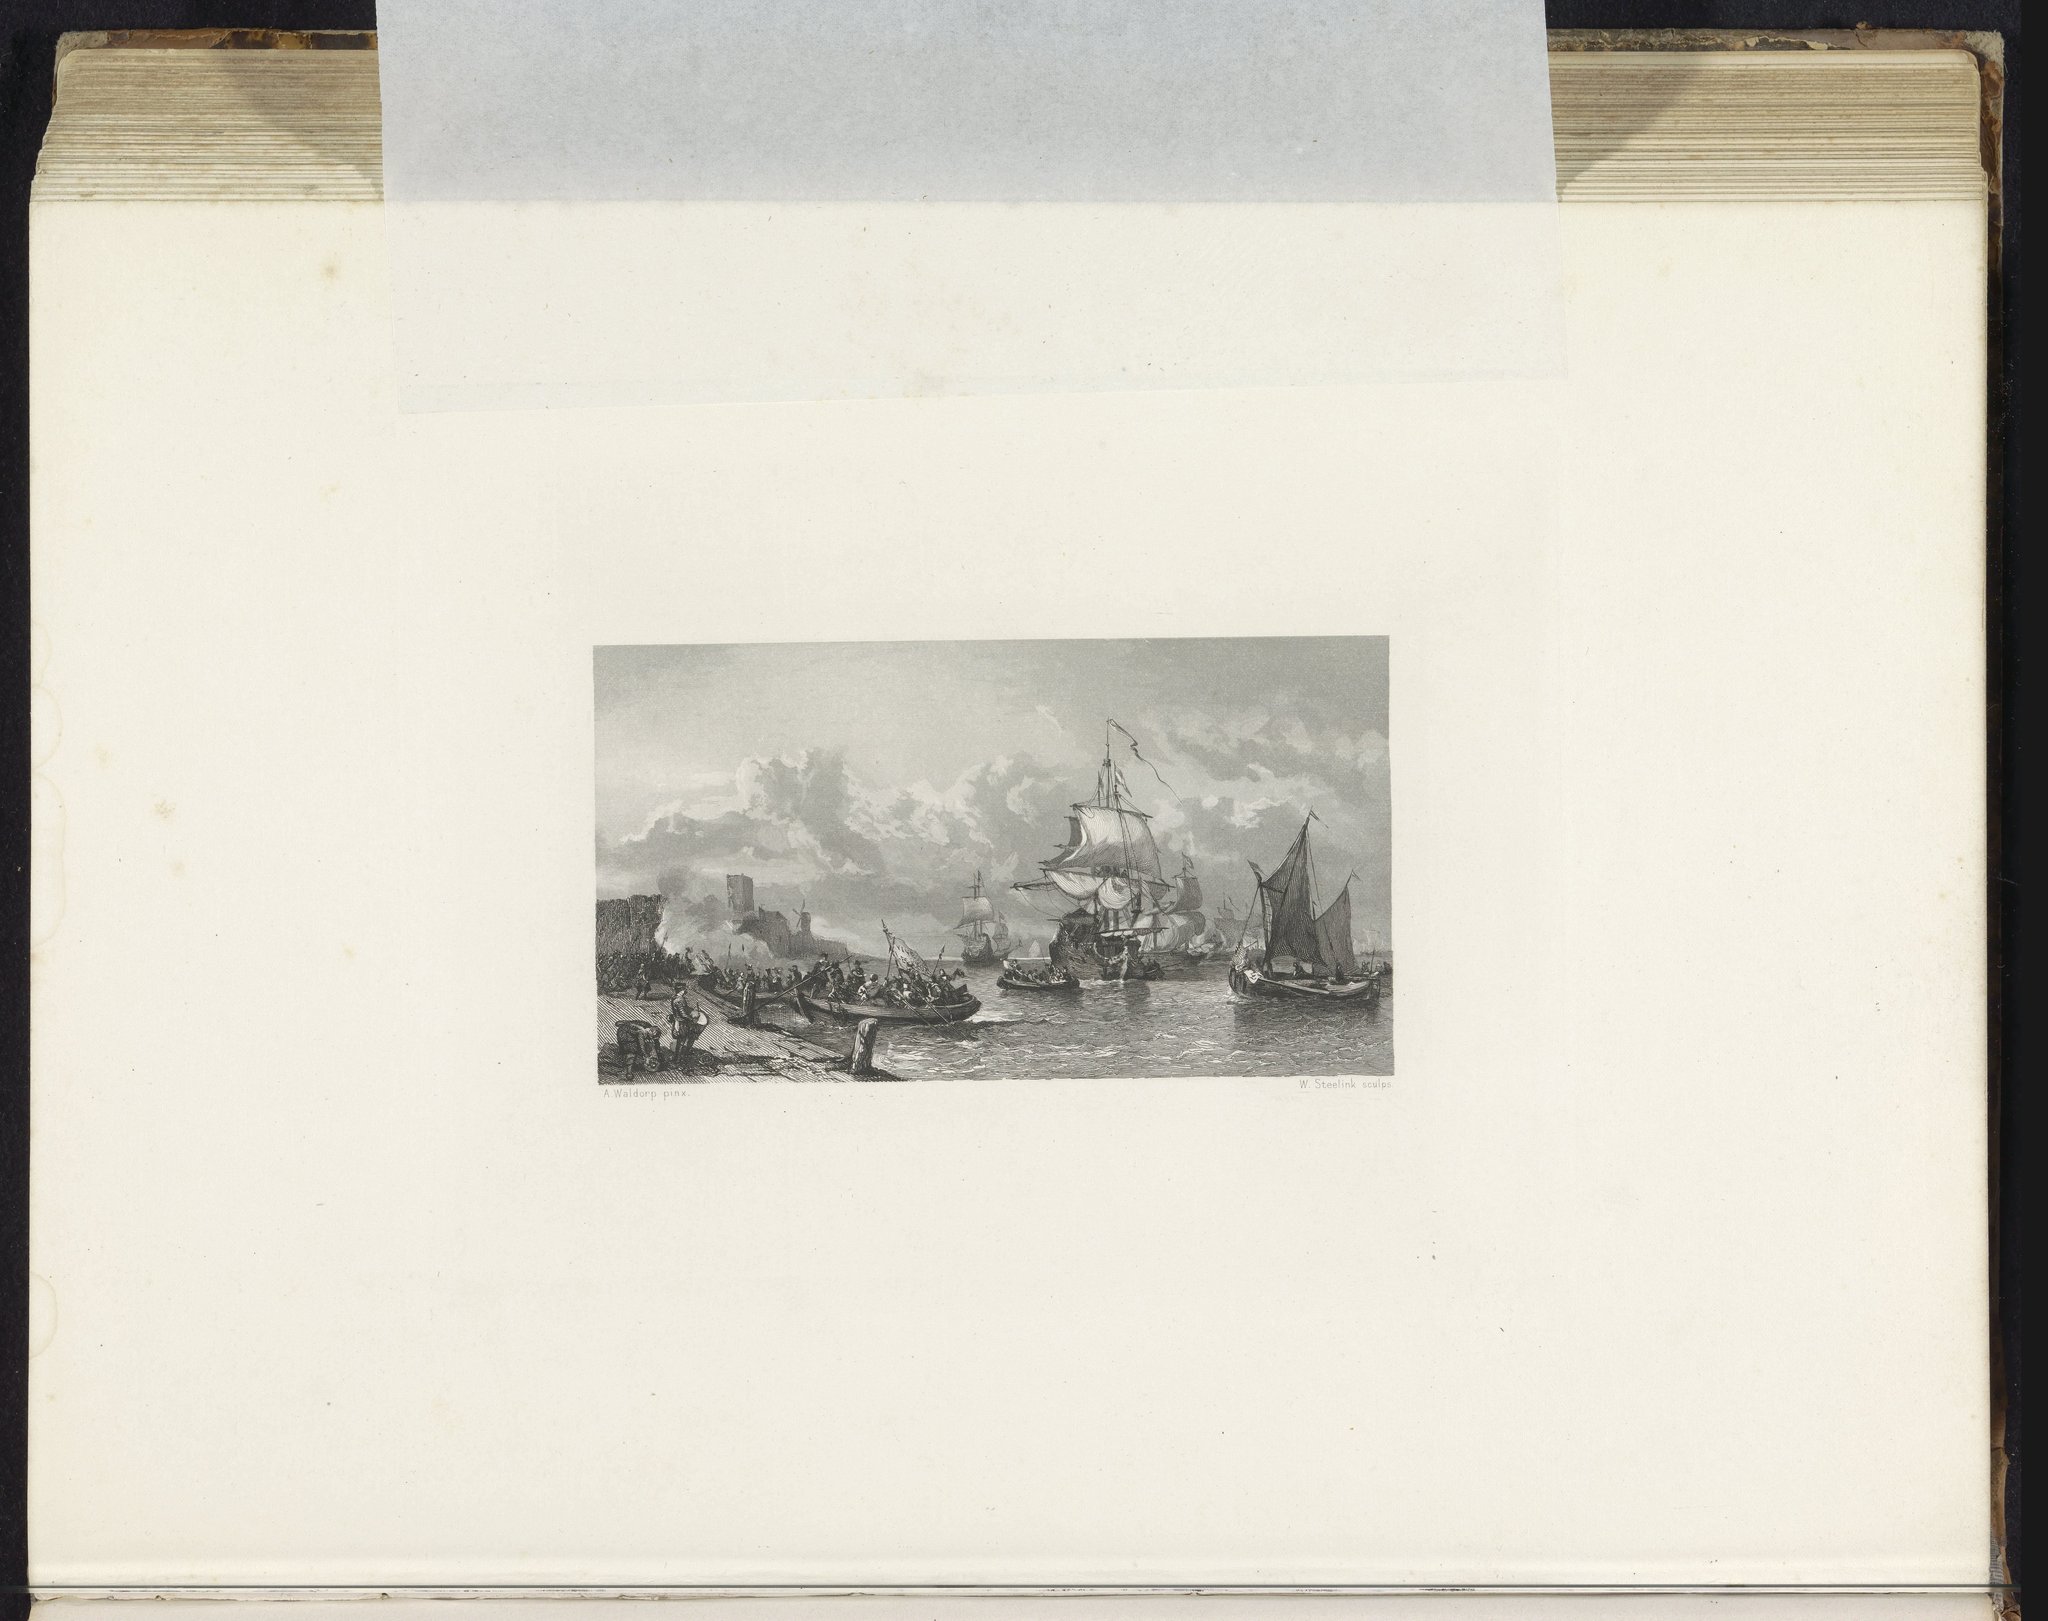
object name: print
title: Inneming van Den Briel door de Watergeuzen. 1 April 1572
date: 1865-1870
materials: paper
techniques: engraving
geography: netherlands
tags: brielle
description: Inname van Den Briel, 1 april 1572. De watergeuzen komen in met kleine boten aan wal. Onderdeel van de groep staalgravures naar de schilderijen van de Historische Galerij der Maatschappij Arti et Amicitiae.